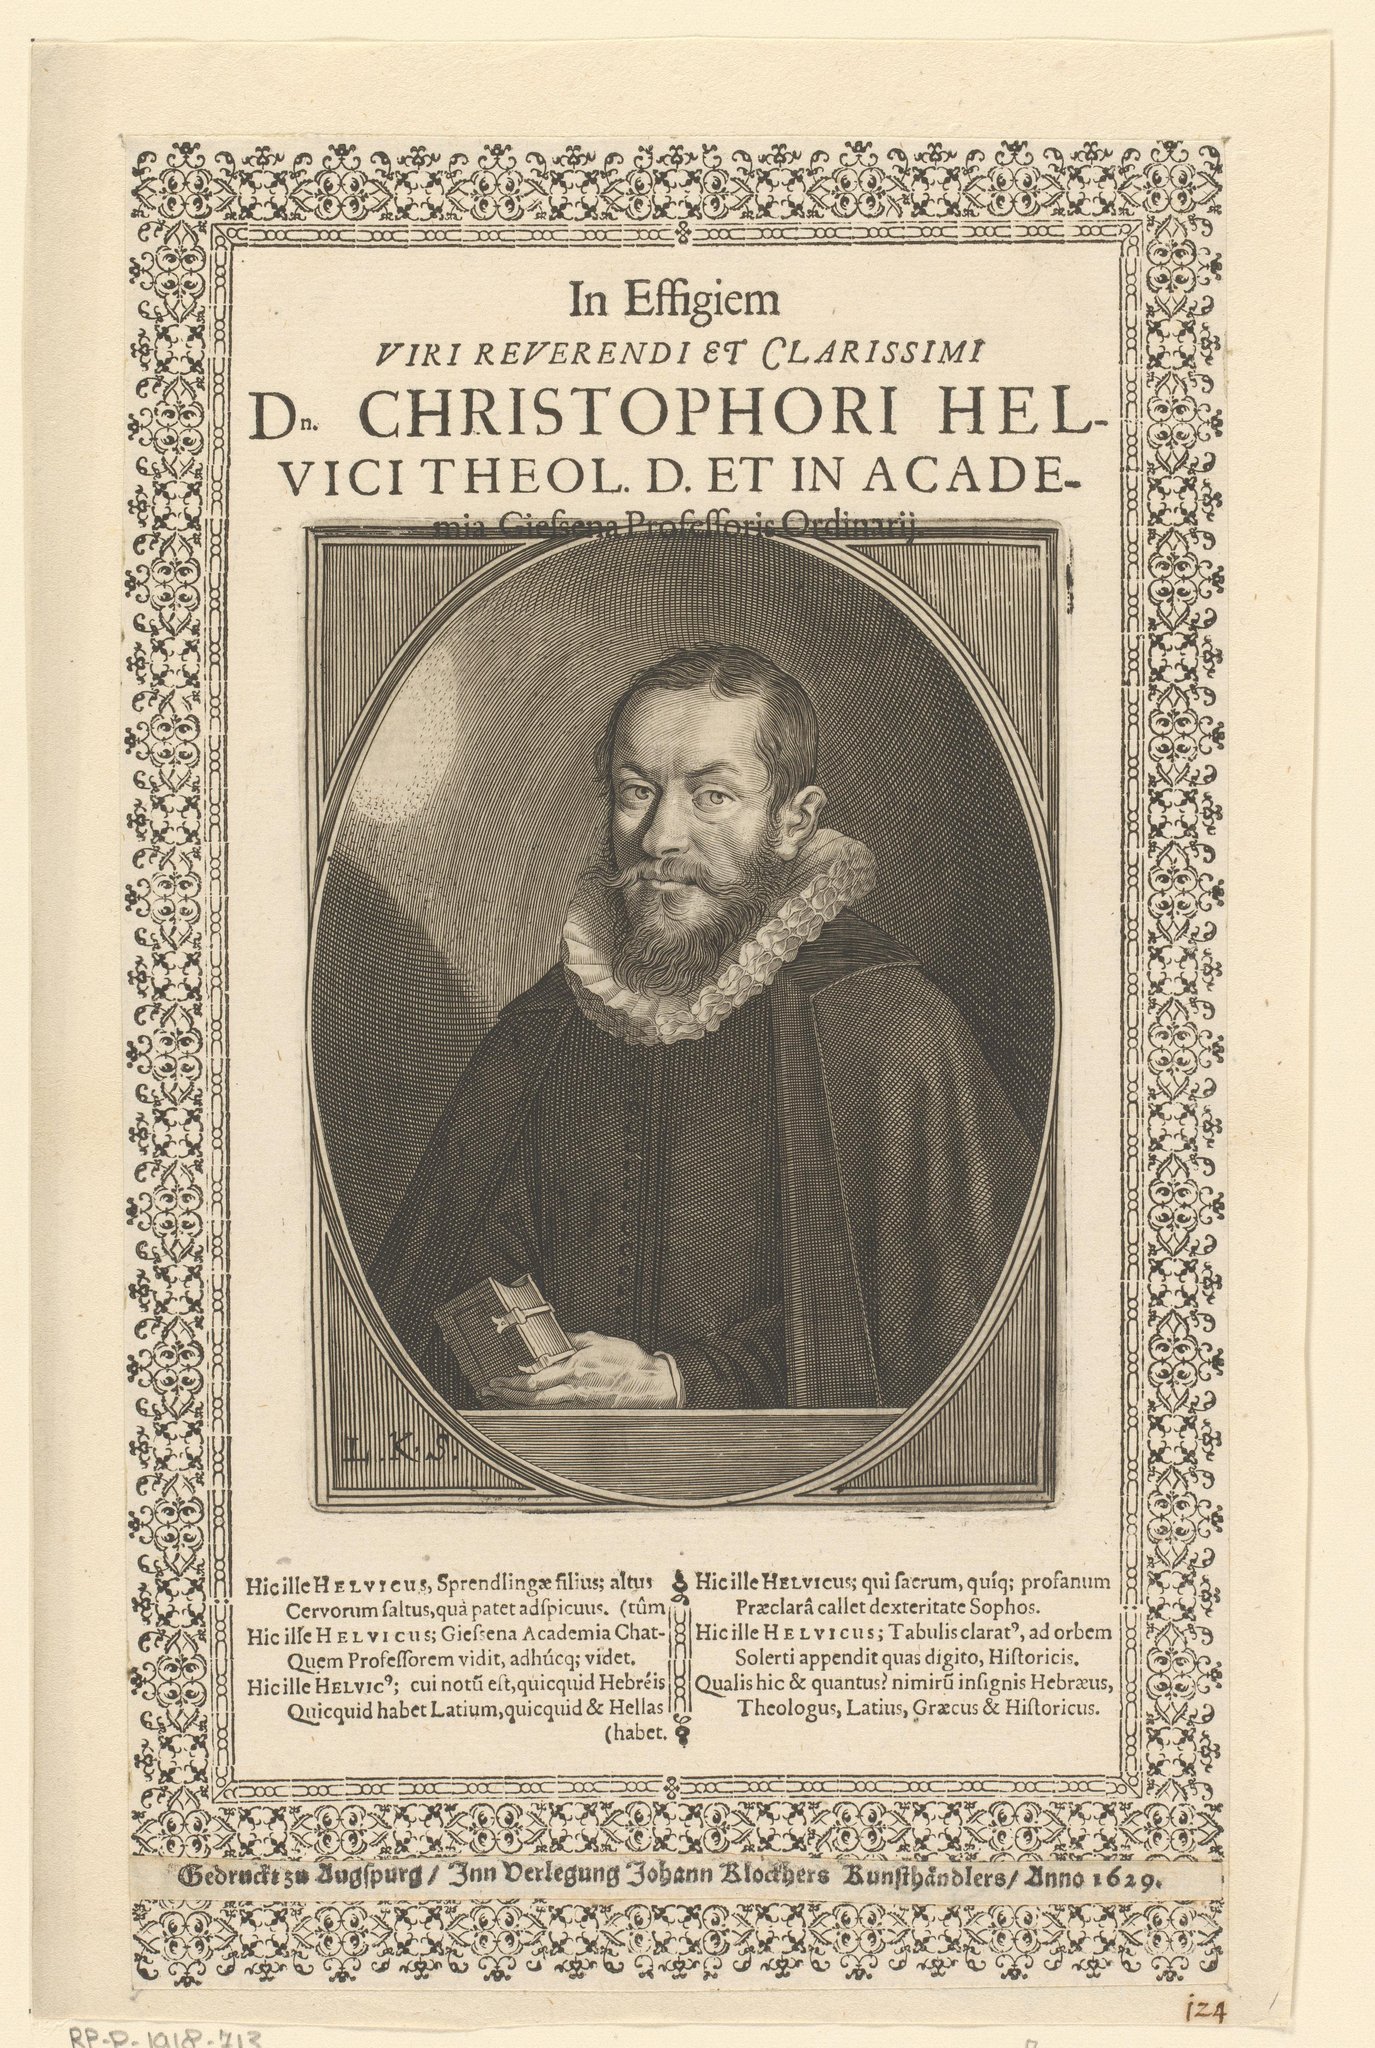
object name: print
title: Portret van Christoph Helwig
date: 1629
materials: paper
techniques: engraving, letterpress printing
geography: augsburg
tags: historical persons, book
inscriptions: collector's mark: Lugt 2233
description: Onder zijn portret een twaalfregelig vers.